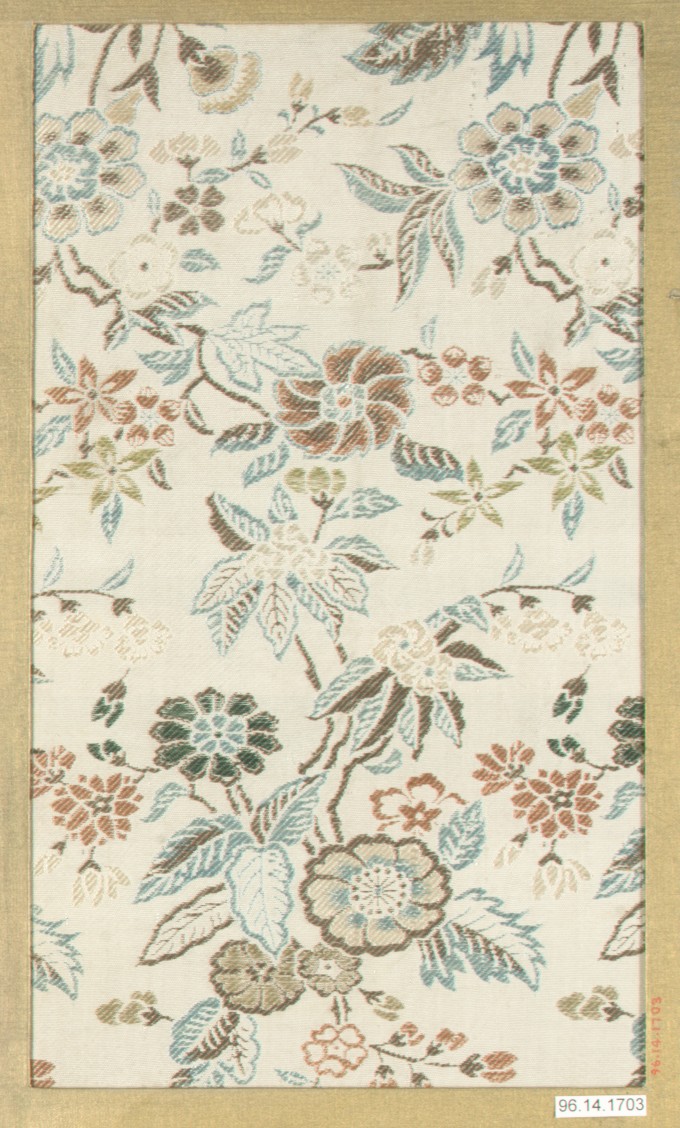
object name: piece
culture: japanese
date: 1701-1900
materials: silk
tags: leaves